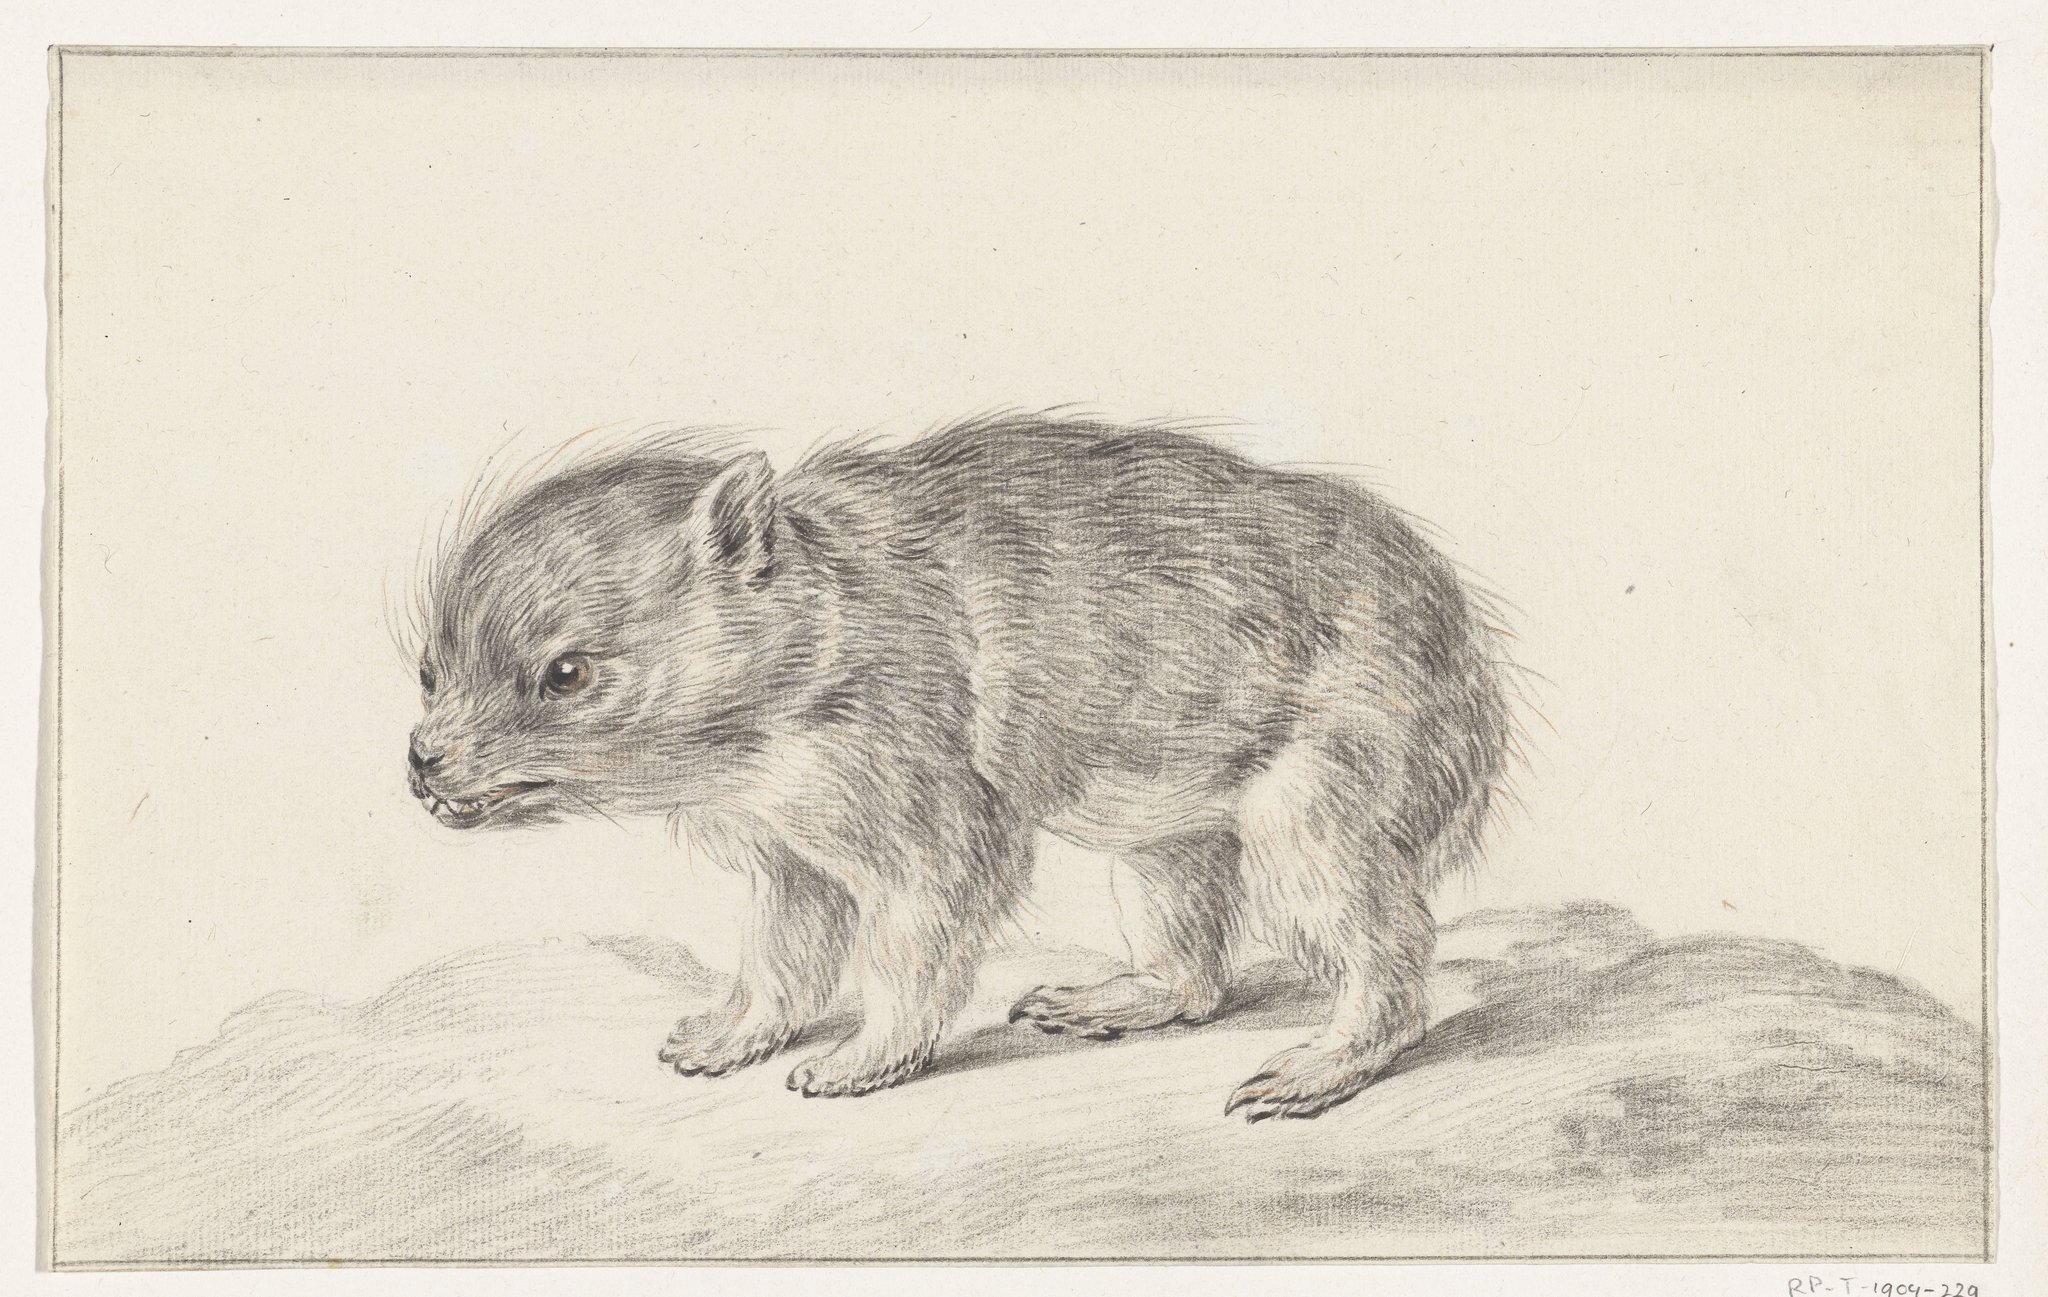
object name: drawing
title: Jong beertje (?)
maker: jean bernard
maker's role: draughtsman, print maker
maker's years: 1765-1833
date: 1775-1833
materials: chalk, paper, pencil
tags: beasts of prey, predatory animals: bear